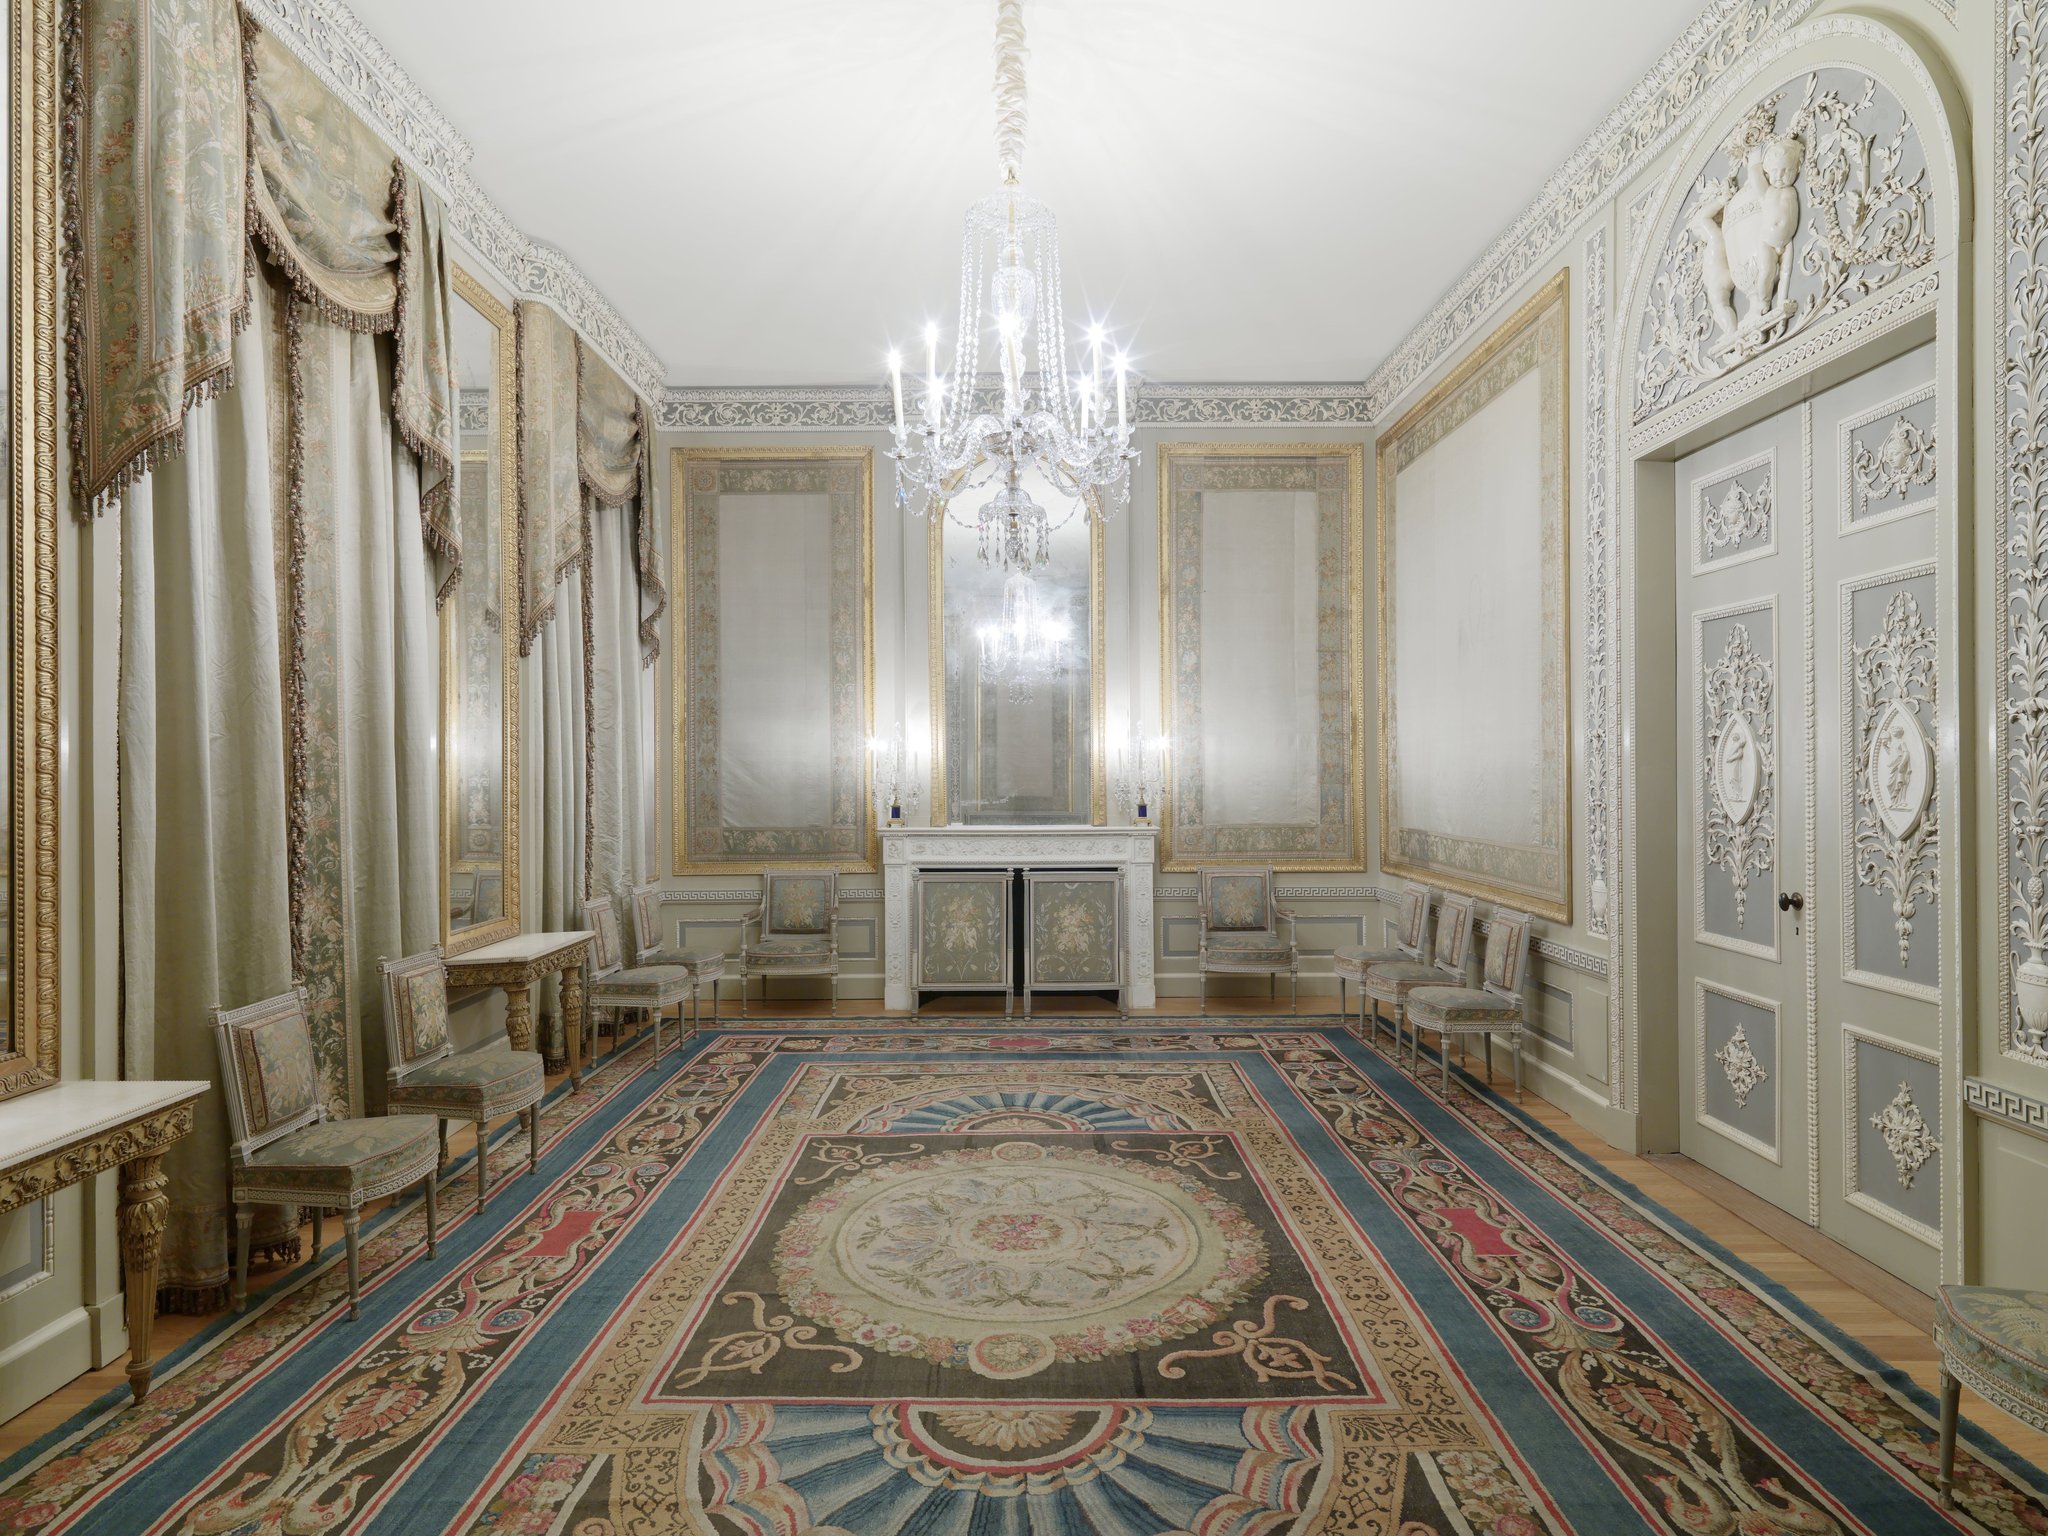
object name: interieuronderdeel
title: Haarlem reception room 1794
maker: abraham van der hart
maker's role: draughtsman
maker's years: 1747-1820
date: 1793-1795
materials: wood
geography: amsterdam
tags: haarlem, ornaments ~ art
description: This room was built and furnished for Willem Philip Kops, a merchant and art collector, as an addition to his house at 74 Nieuwe Gracht in Haarlem. With the exception of the original stucco ceiling, the room survives virtually intact. Abraham van der Hart, the city architect of Amsterdam, succeeded in creating a harmonious, classicizing entity, in which all the arts are in tune with one another. He must have been assisted by a specialized firm of upholsterers, which ordered the furnishings and coordinated the installation. The chimneypiece probably came from Italy, the carpet from the Flemish city of Tournai, the furniture from Amsterdam, the silk hangings and upholstery from Lyon in France and the glass chandelier and candelabra from England. The room was most likely used only for formal evening receptions.